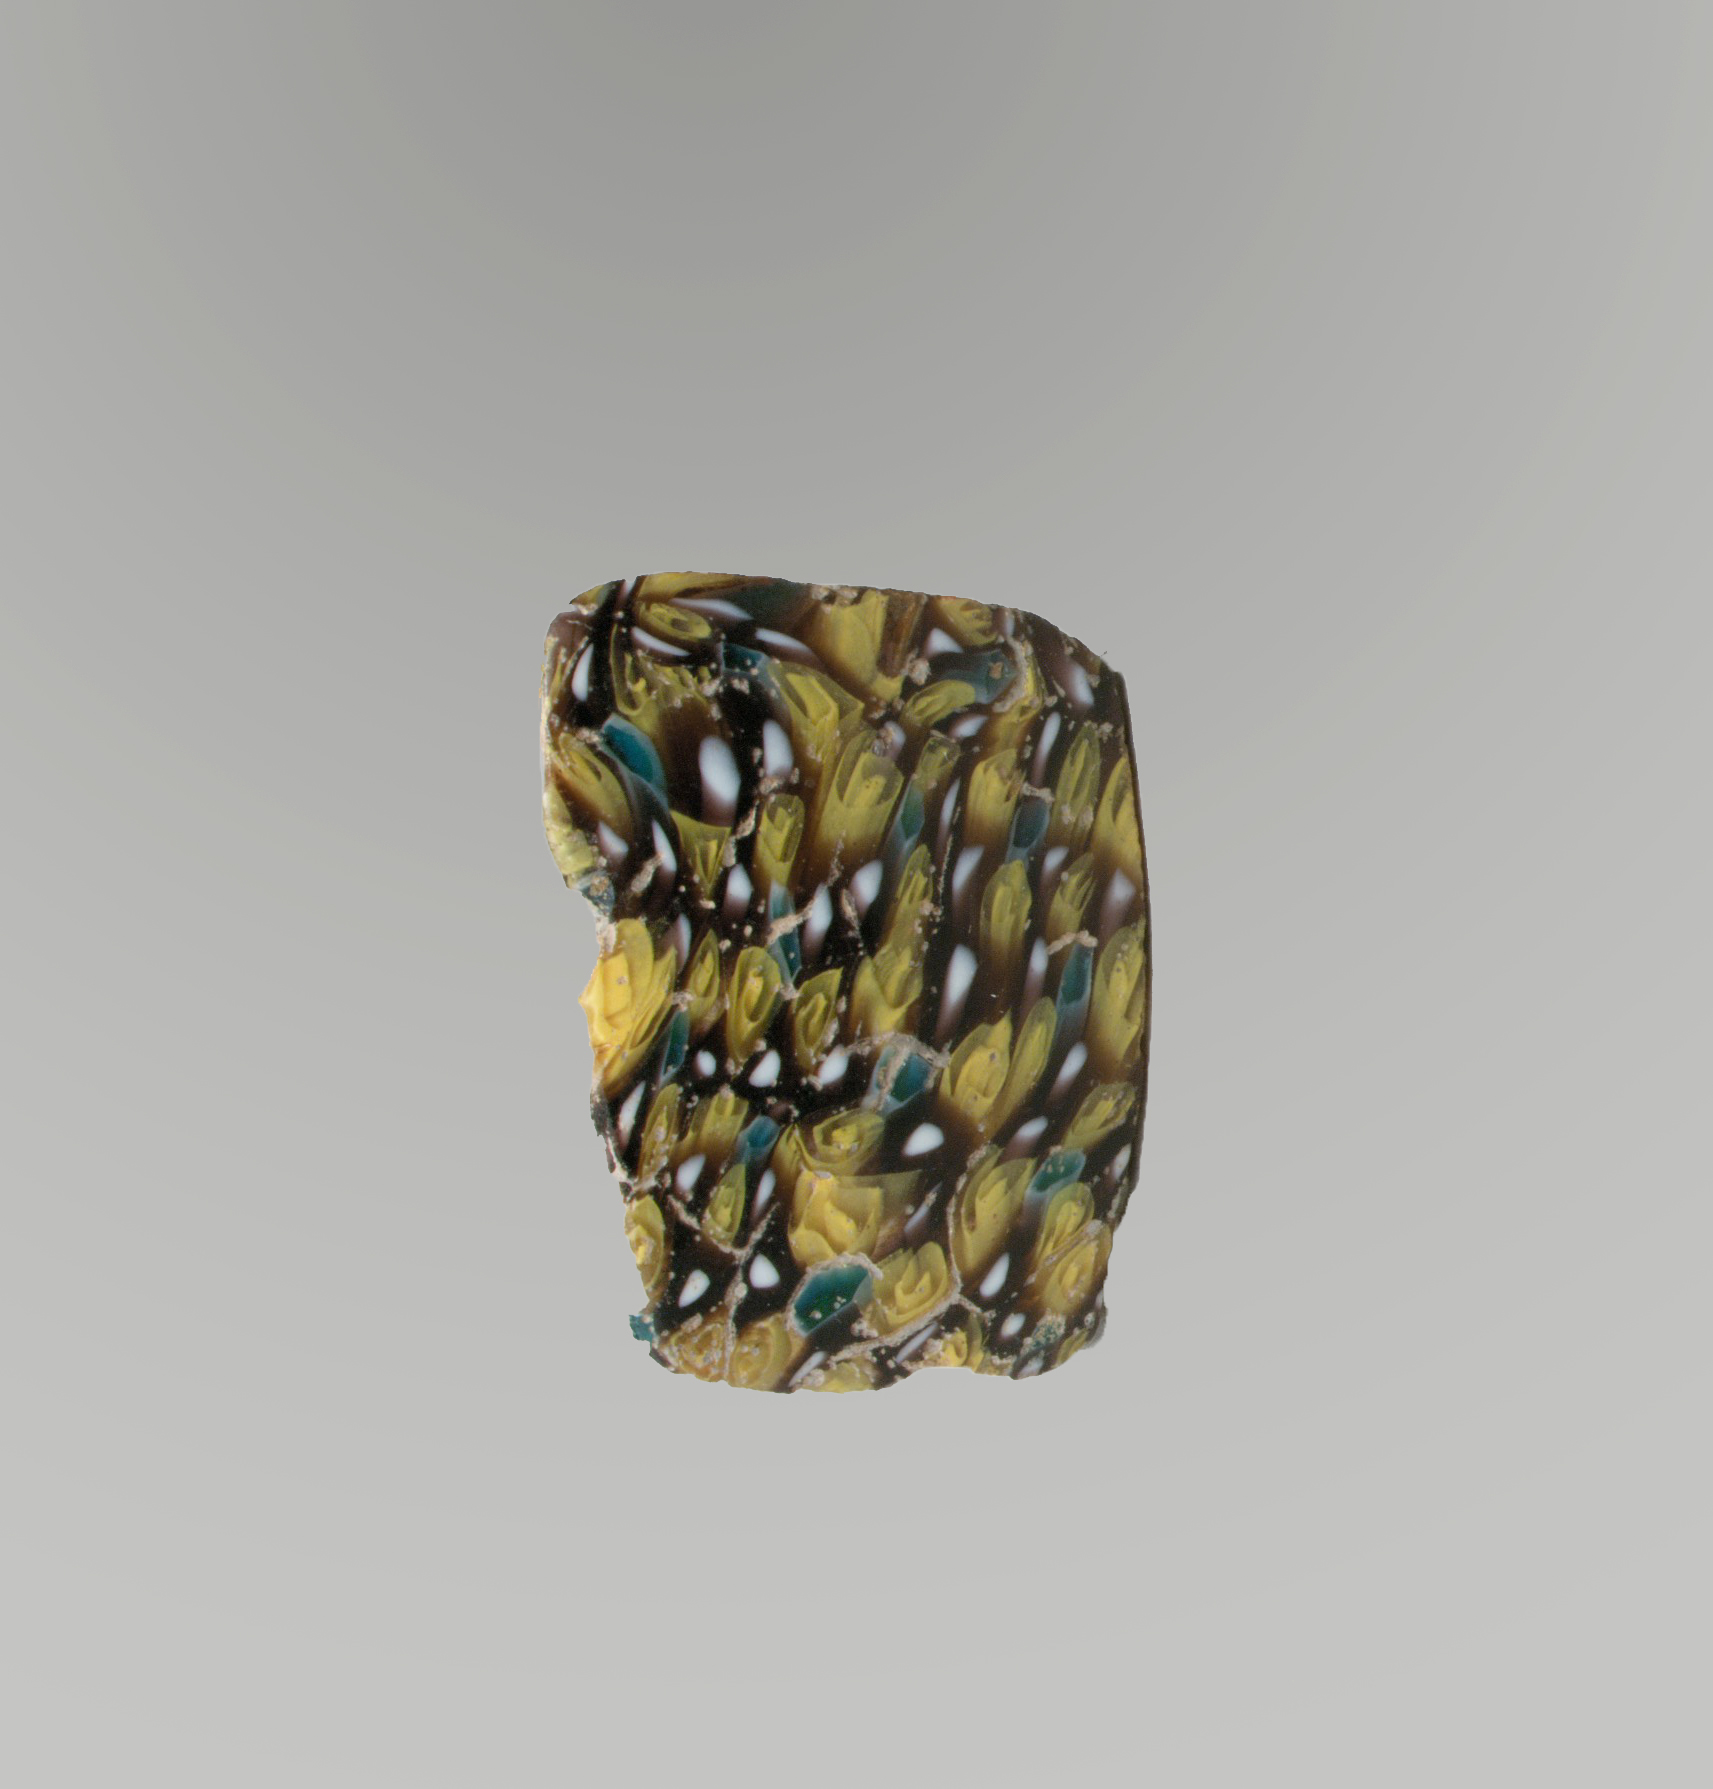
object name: fragment, mosaic bowl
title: Glass mosaic bowl fragment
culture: roman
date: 34 BCE-33 CE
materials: glass